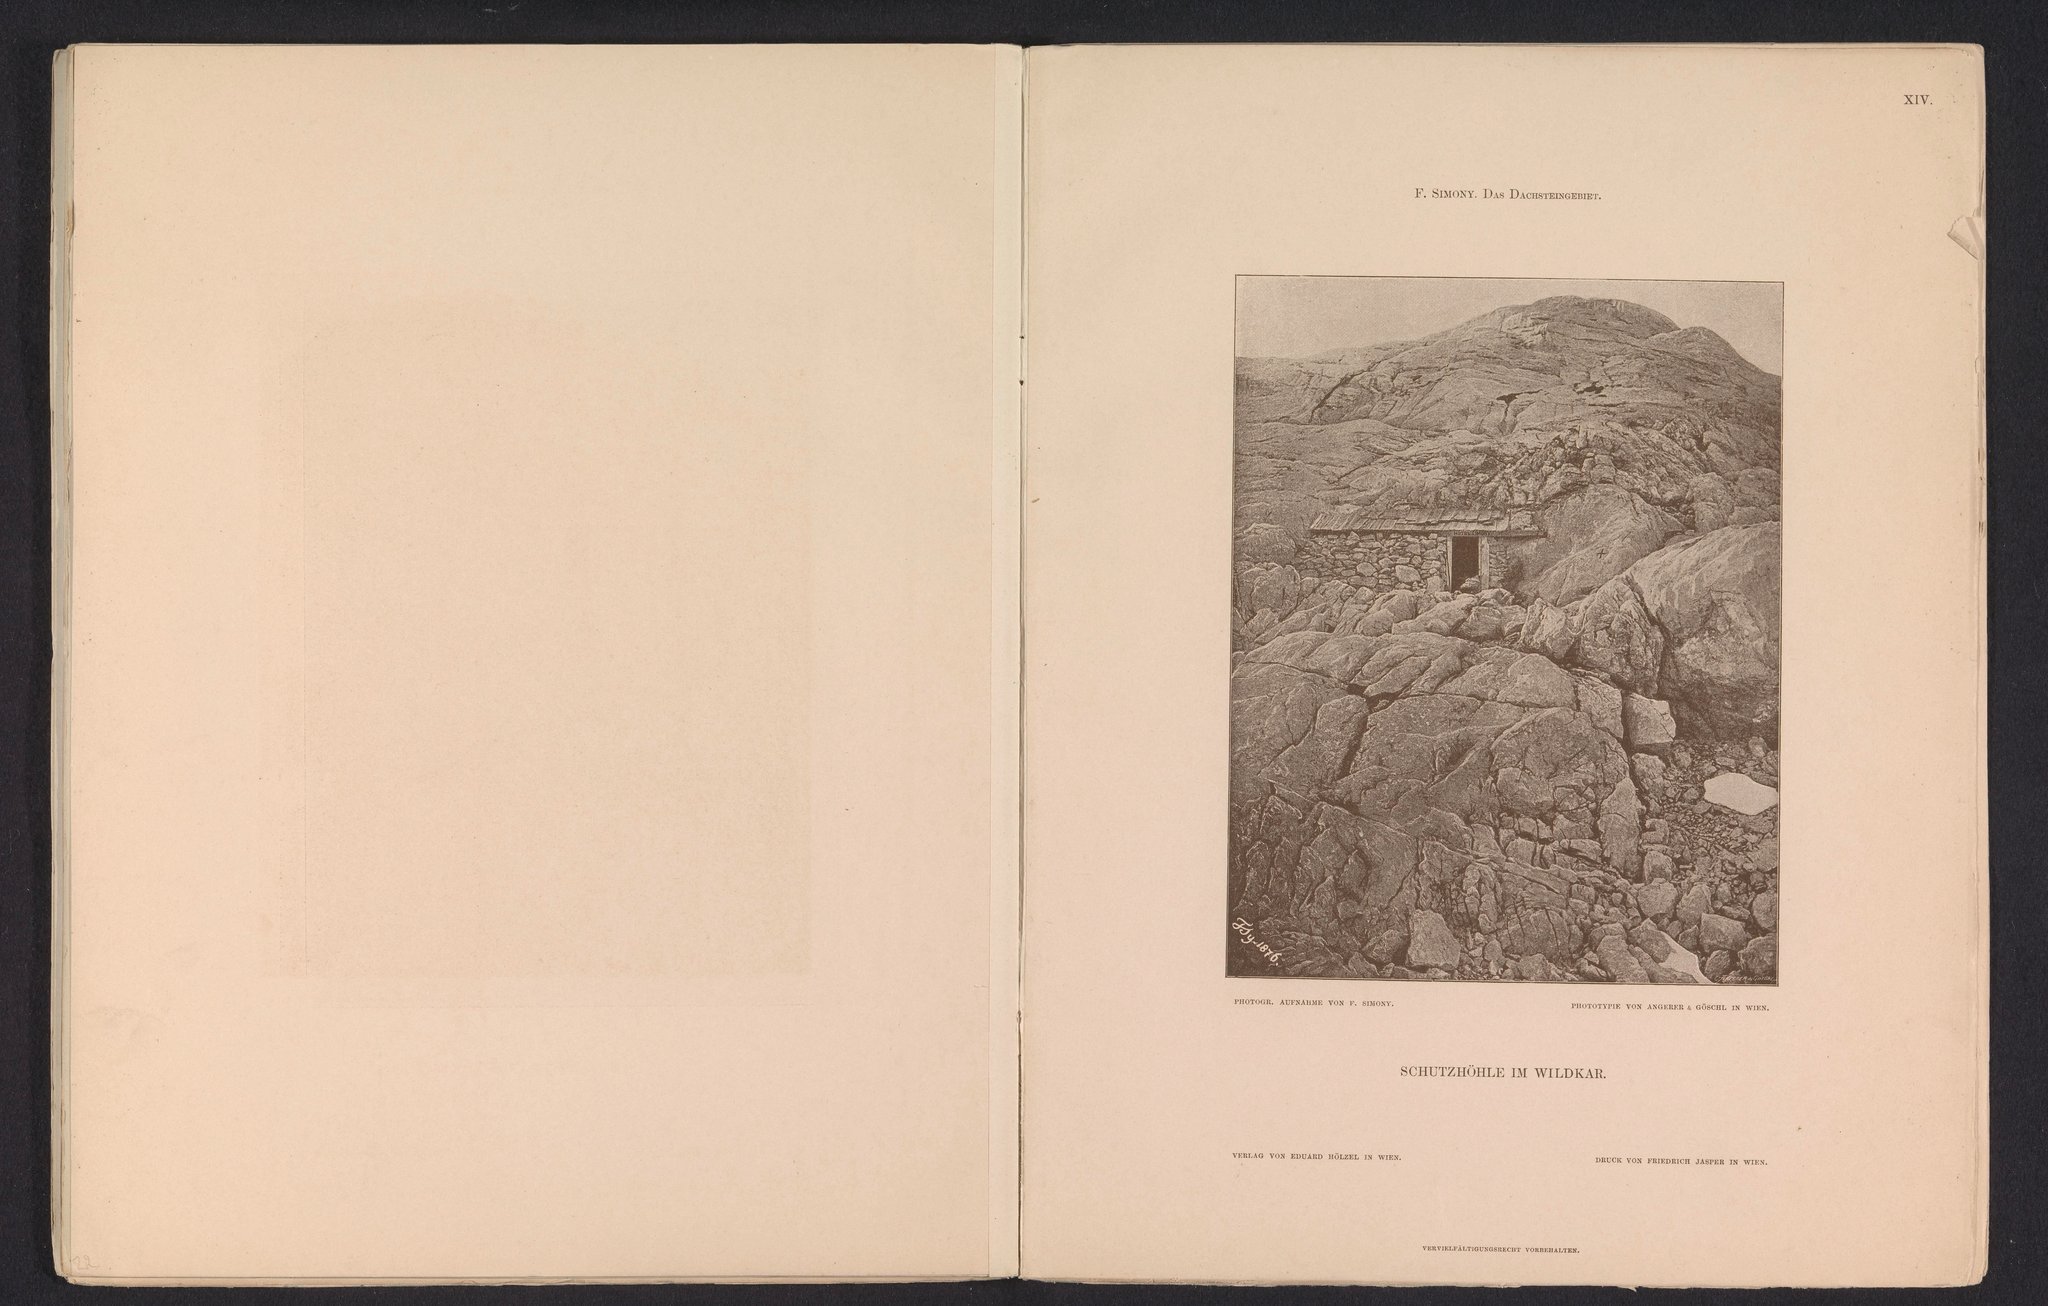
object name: page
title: Schutzhöhle im Wildkar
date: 1876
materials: paper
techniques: autotype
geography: vienna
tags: mountain-top, peak, hut, cabin, lodge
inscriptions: number: ‘XIV.’